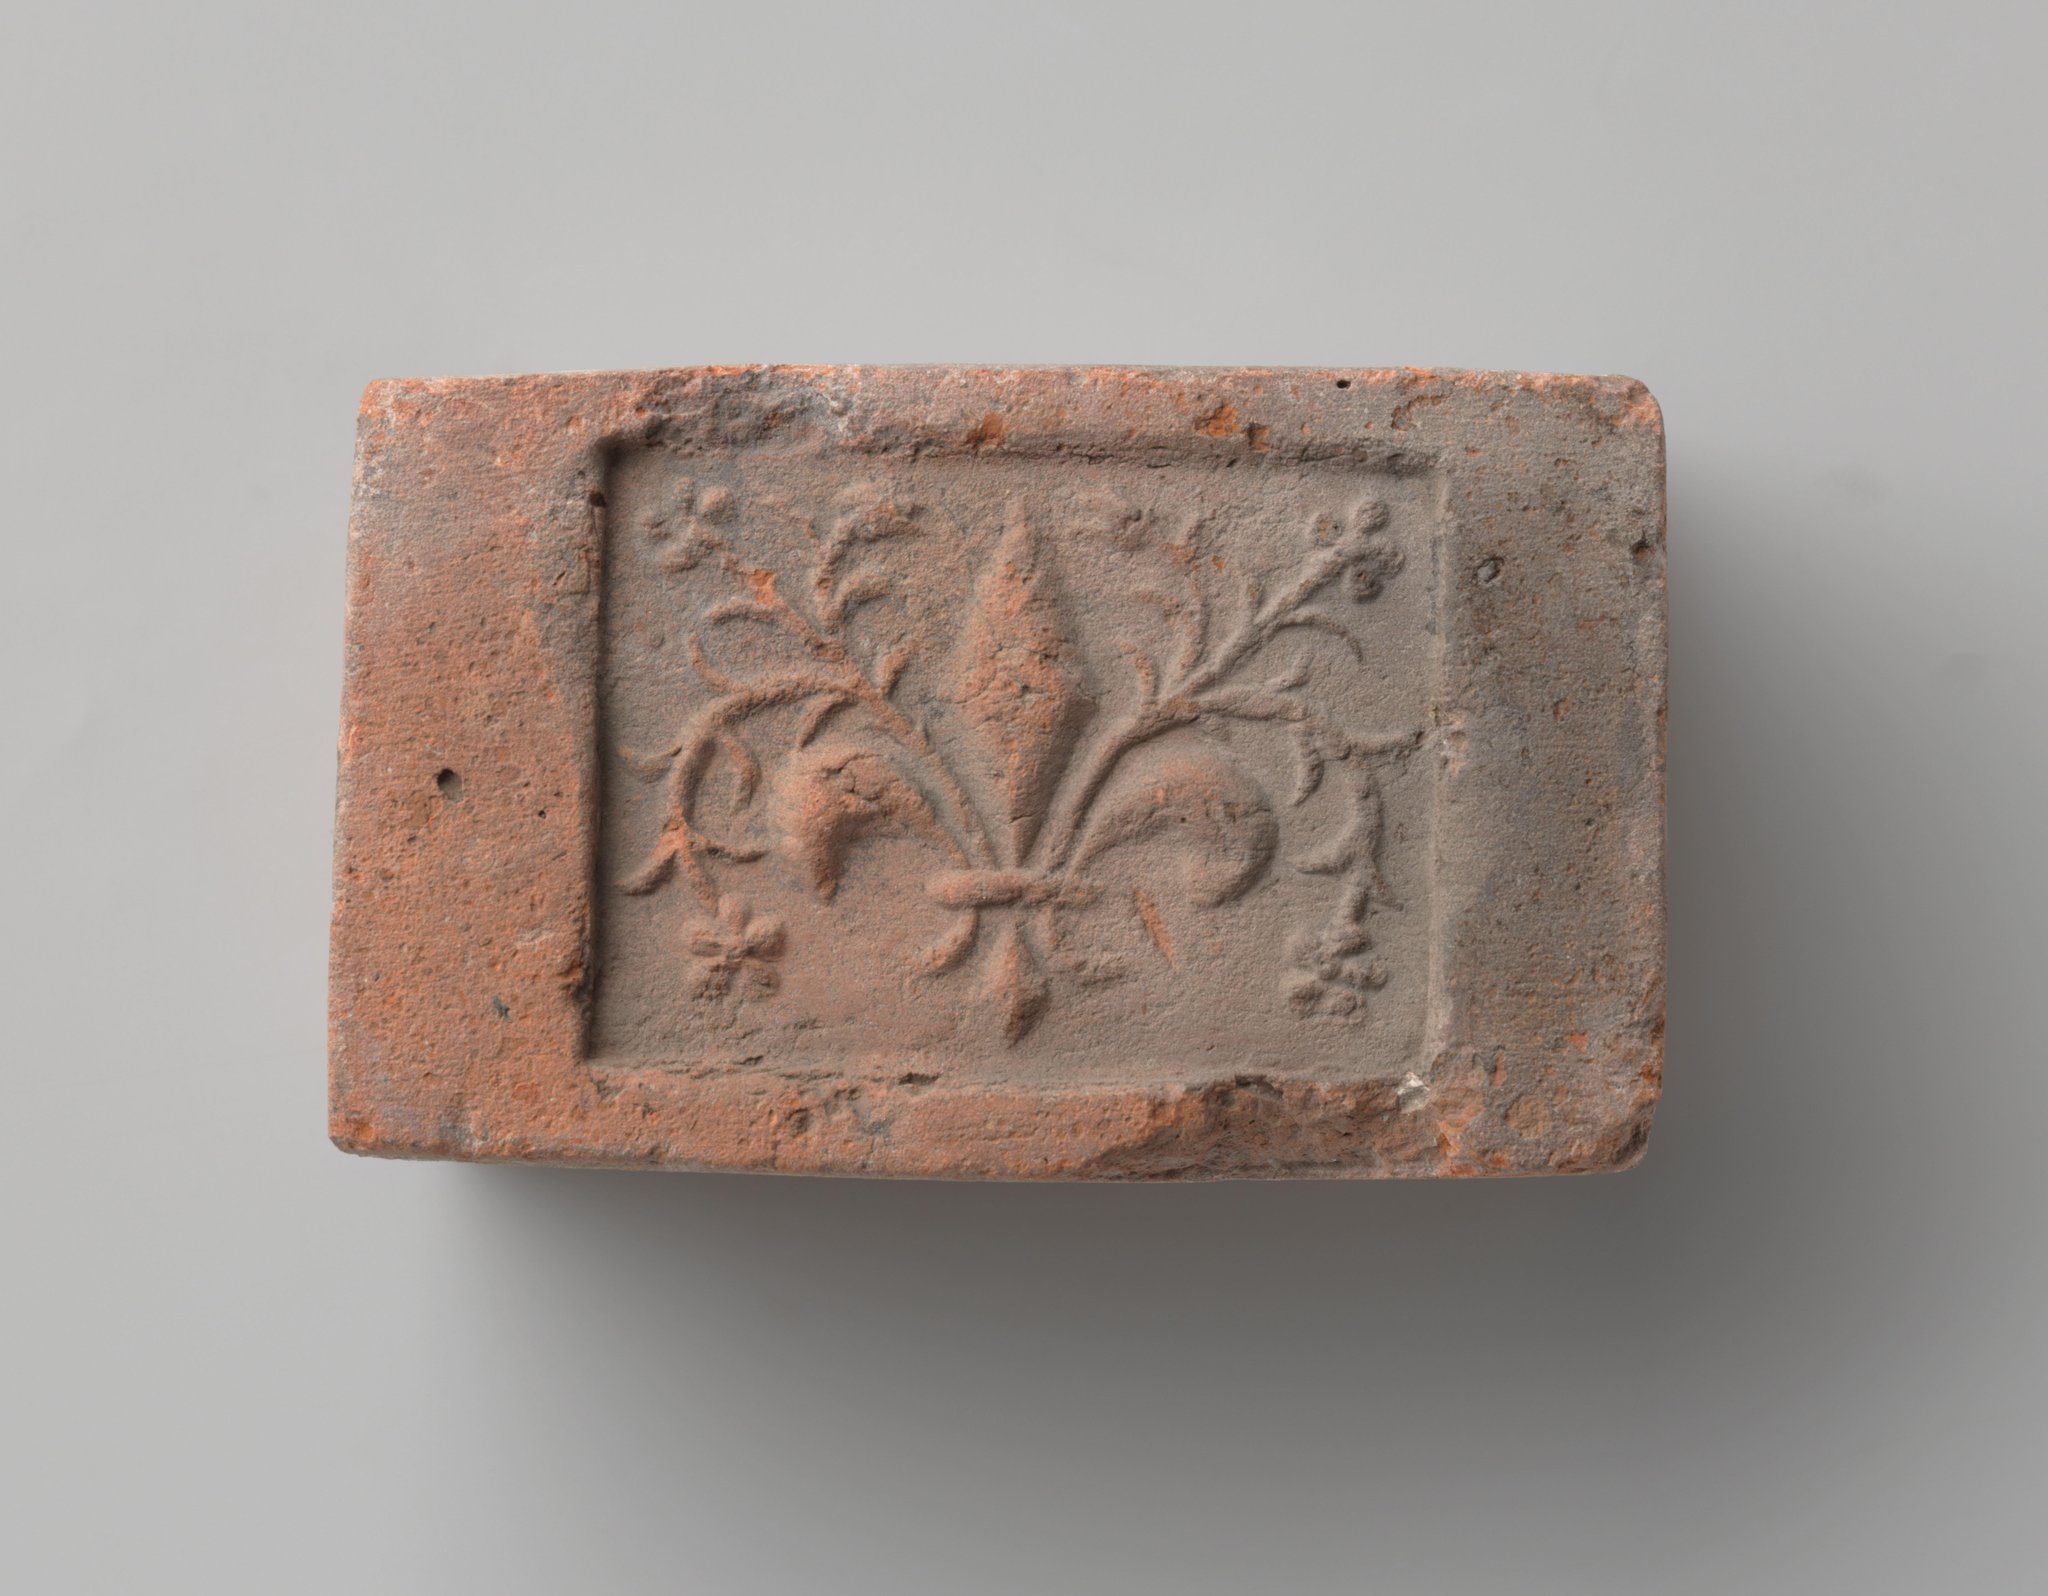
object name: hearthstone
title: Haardsteen met voorstelling van een Franse lelie met bladranken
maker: Anonymous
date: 1575-1600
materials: earthenware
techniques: printing, firing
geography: southern netherlands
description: Haardsteen met voorstelling van een Franse lelie met bladranken.